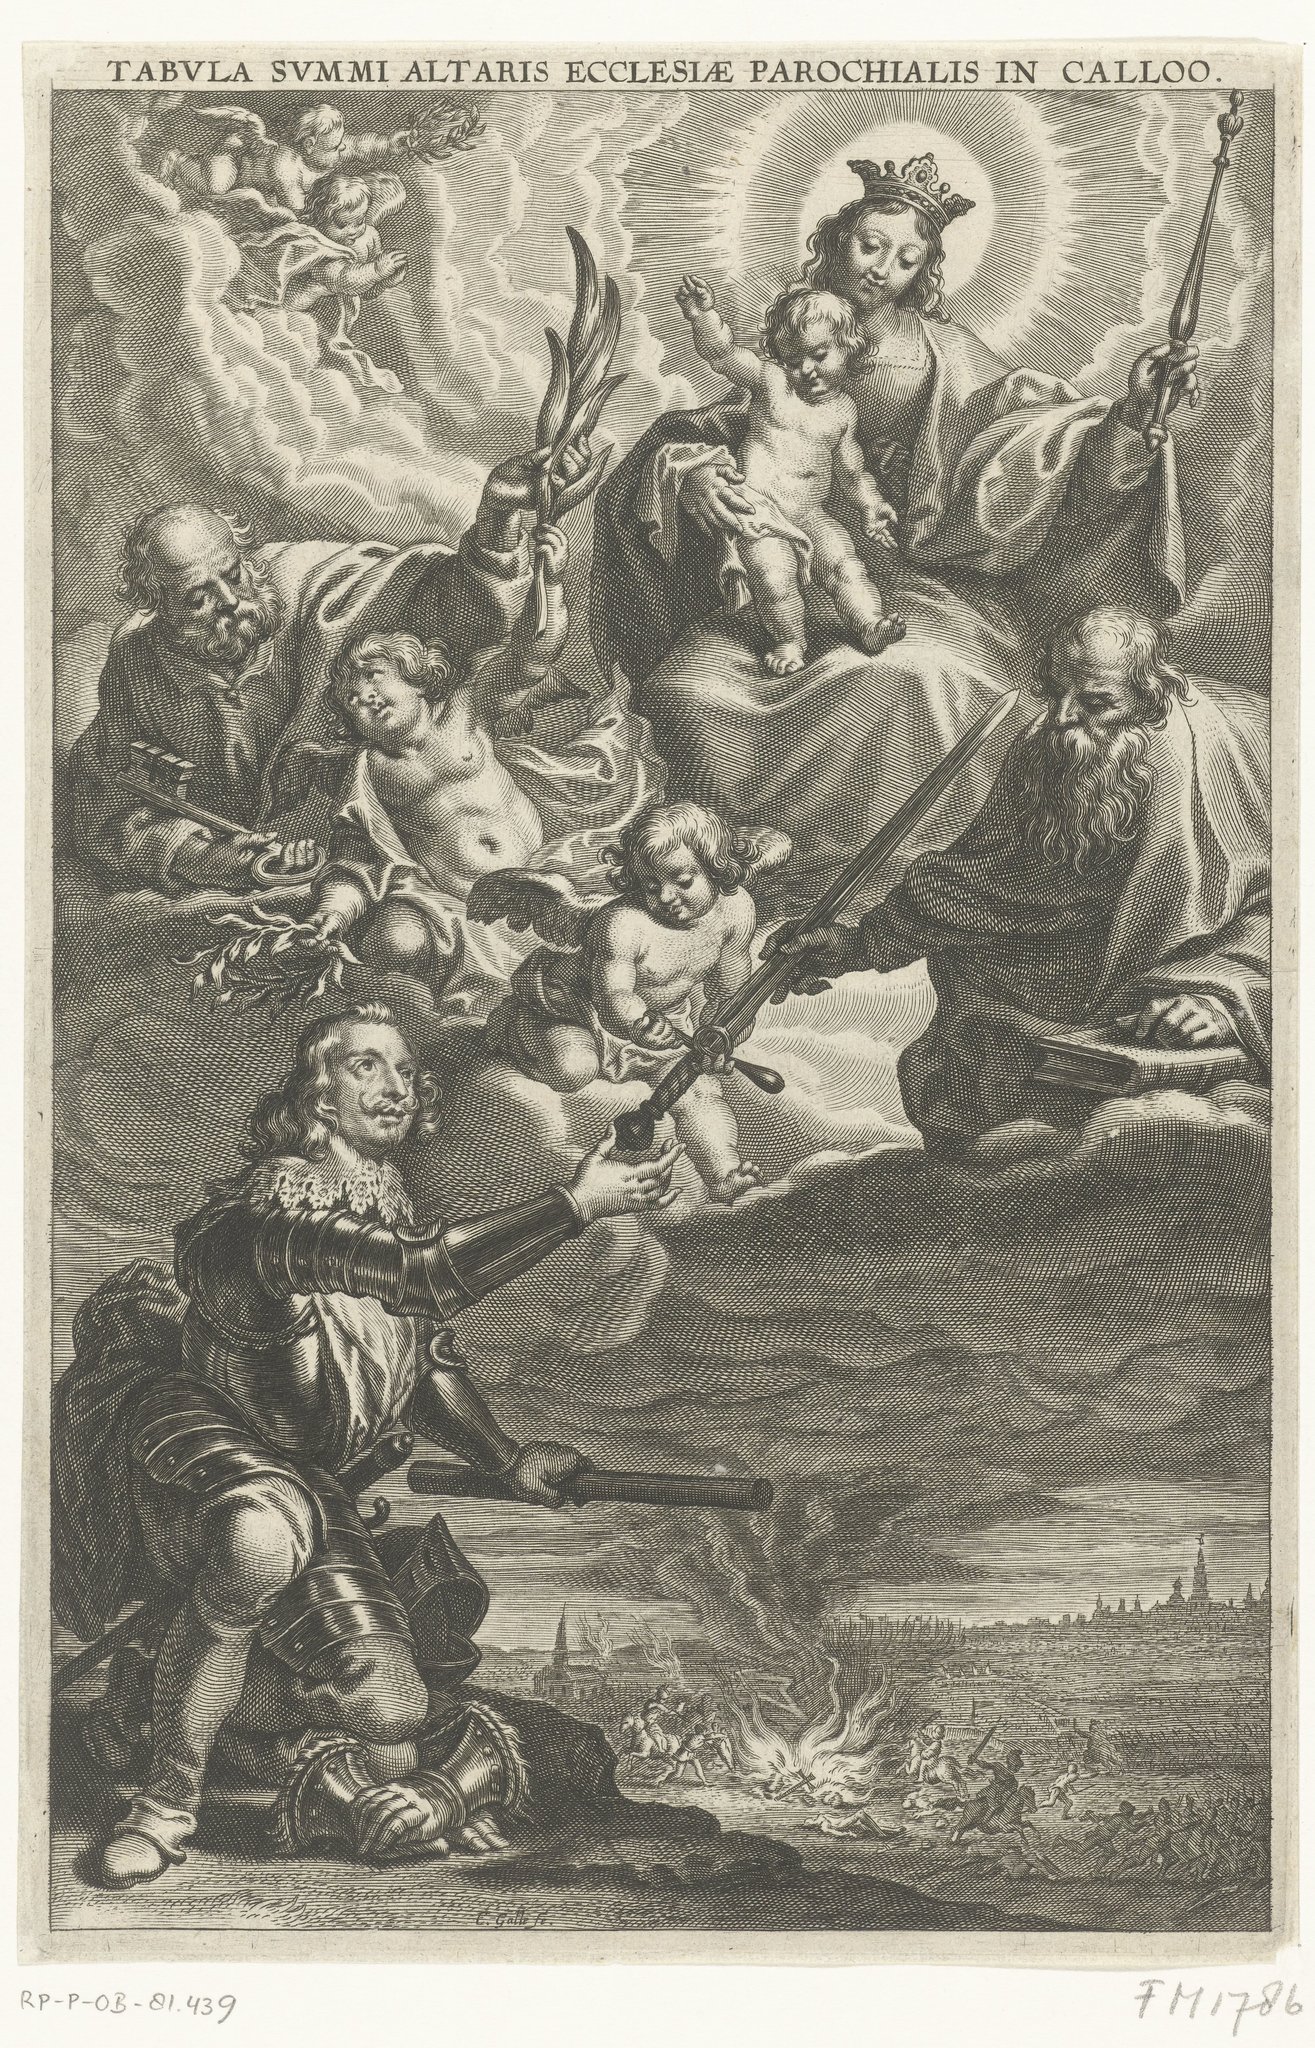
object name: print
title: Tabula summi altaris ecclesiae parochialis in Calloo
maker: cornelis galle (ii)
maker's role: print maker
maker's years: 1615-1678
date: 1638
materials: paper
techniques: engraving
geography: antwerp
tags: brussels, landvoogd der zuidelijke nederlanden ferdinand van oostenrijk, the apostle paul of tarsus; possible attributes: book, scroll, sword, antwerp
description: Ferdinand ontvangt het zwaard om de Staatsen bij Kallo te bestrijden, 1638. De kardinaal-infant ontvangt knielend het zwaard uit de handen van Paulus. In de hemel Maria met kind, Petrus en engelen. Op de achtergrond vluchtende soldaten van het Staatse leger onder graaf Willem van Nassau-Siegen na de mislukte aanval op de schans bij Kallo, 21 juni 1638. Naar het altaarstuk in de kerk te Kallo.